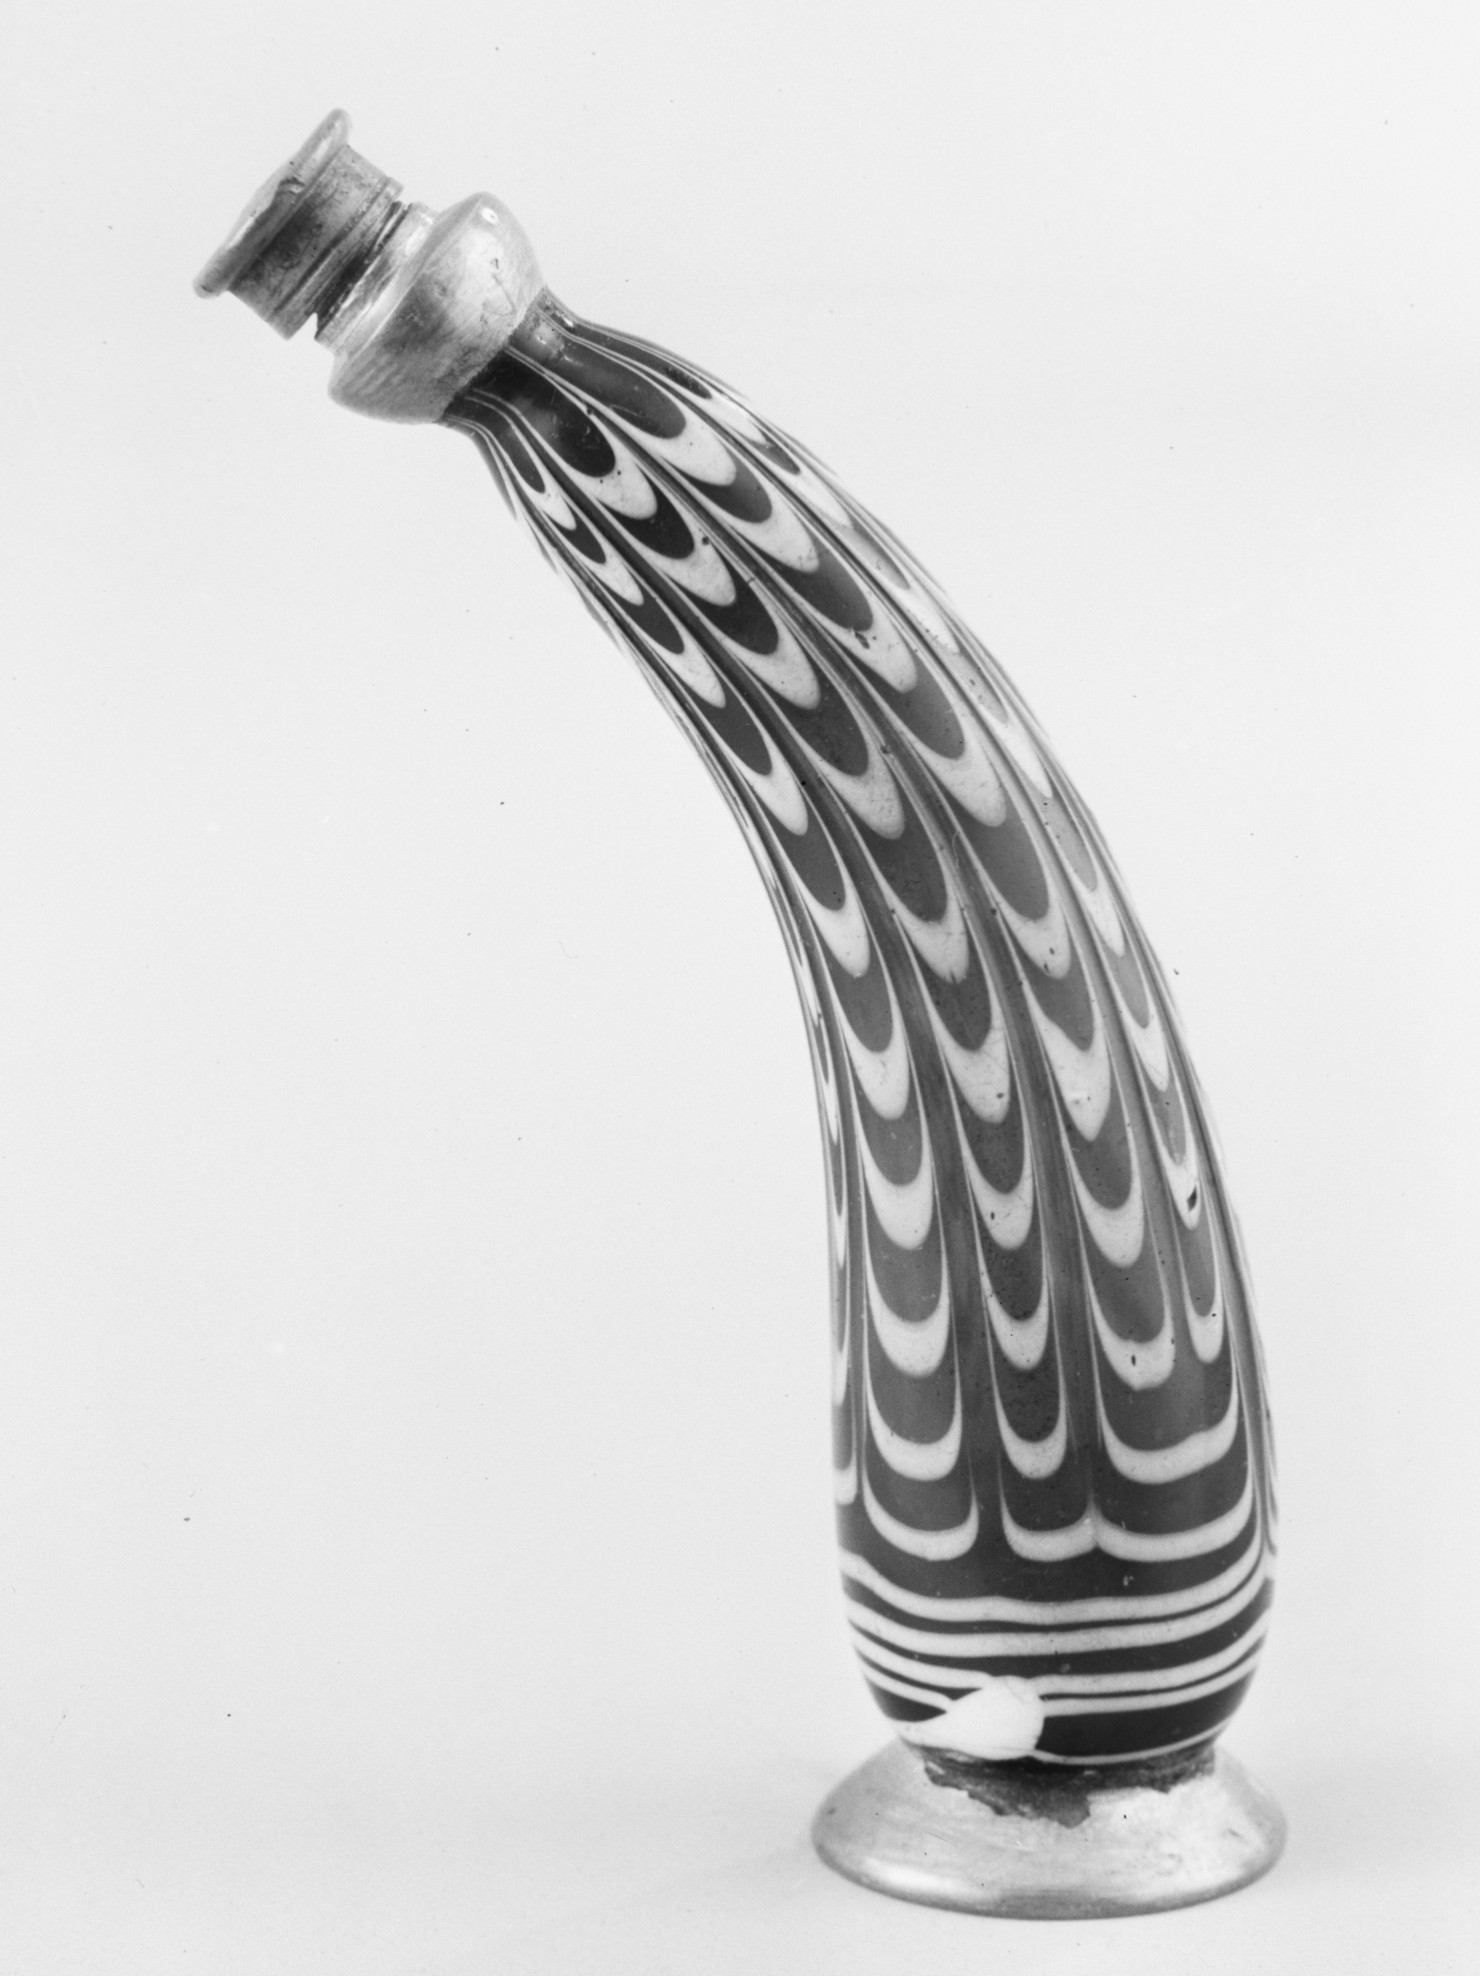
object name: scent bottle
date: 1601-1800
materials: glass, pewter